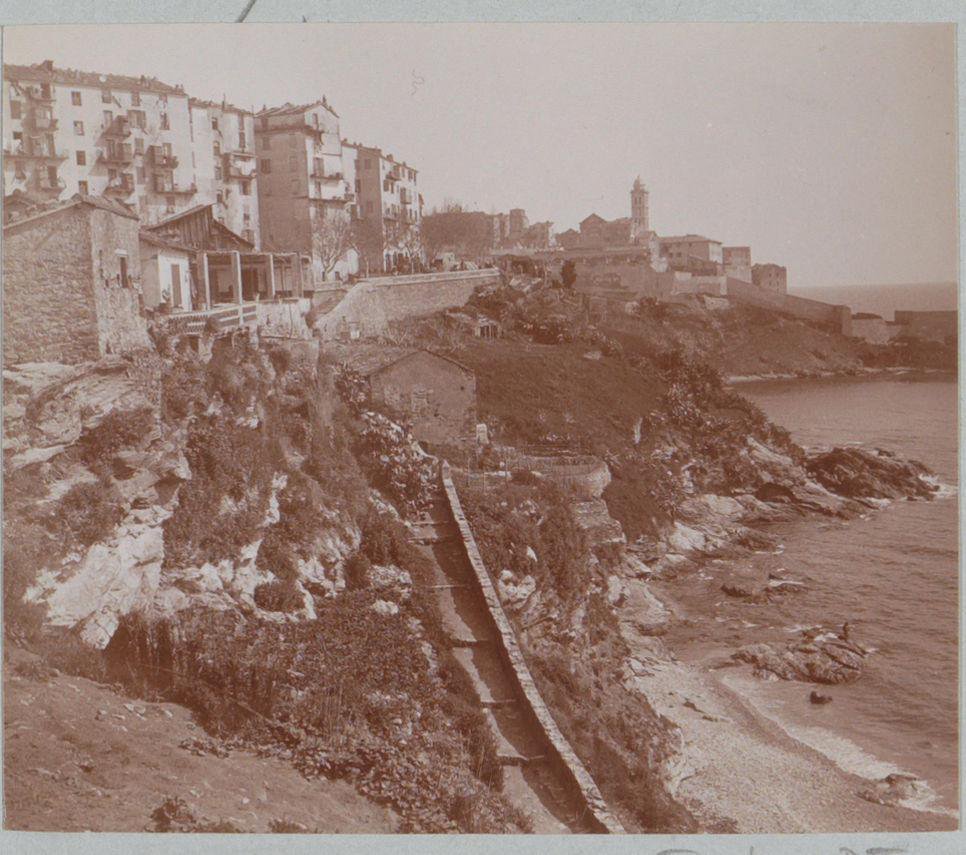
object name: photograph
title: Gezicht op een stad aan zee, vermoedelijk op Corsica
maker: Anonymous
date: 1905-1910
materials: paper, photographic support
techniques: gelatin silver print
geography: corsica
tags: prospect of village, silhouette of village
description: Onderdeel van Fotoalbum van een Franse amateurfotograaf met bezienswaardigheden in Frankrijk, Zwitserland en Italië.